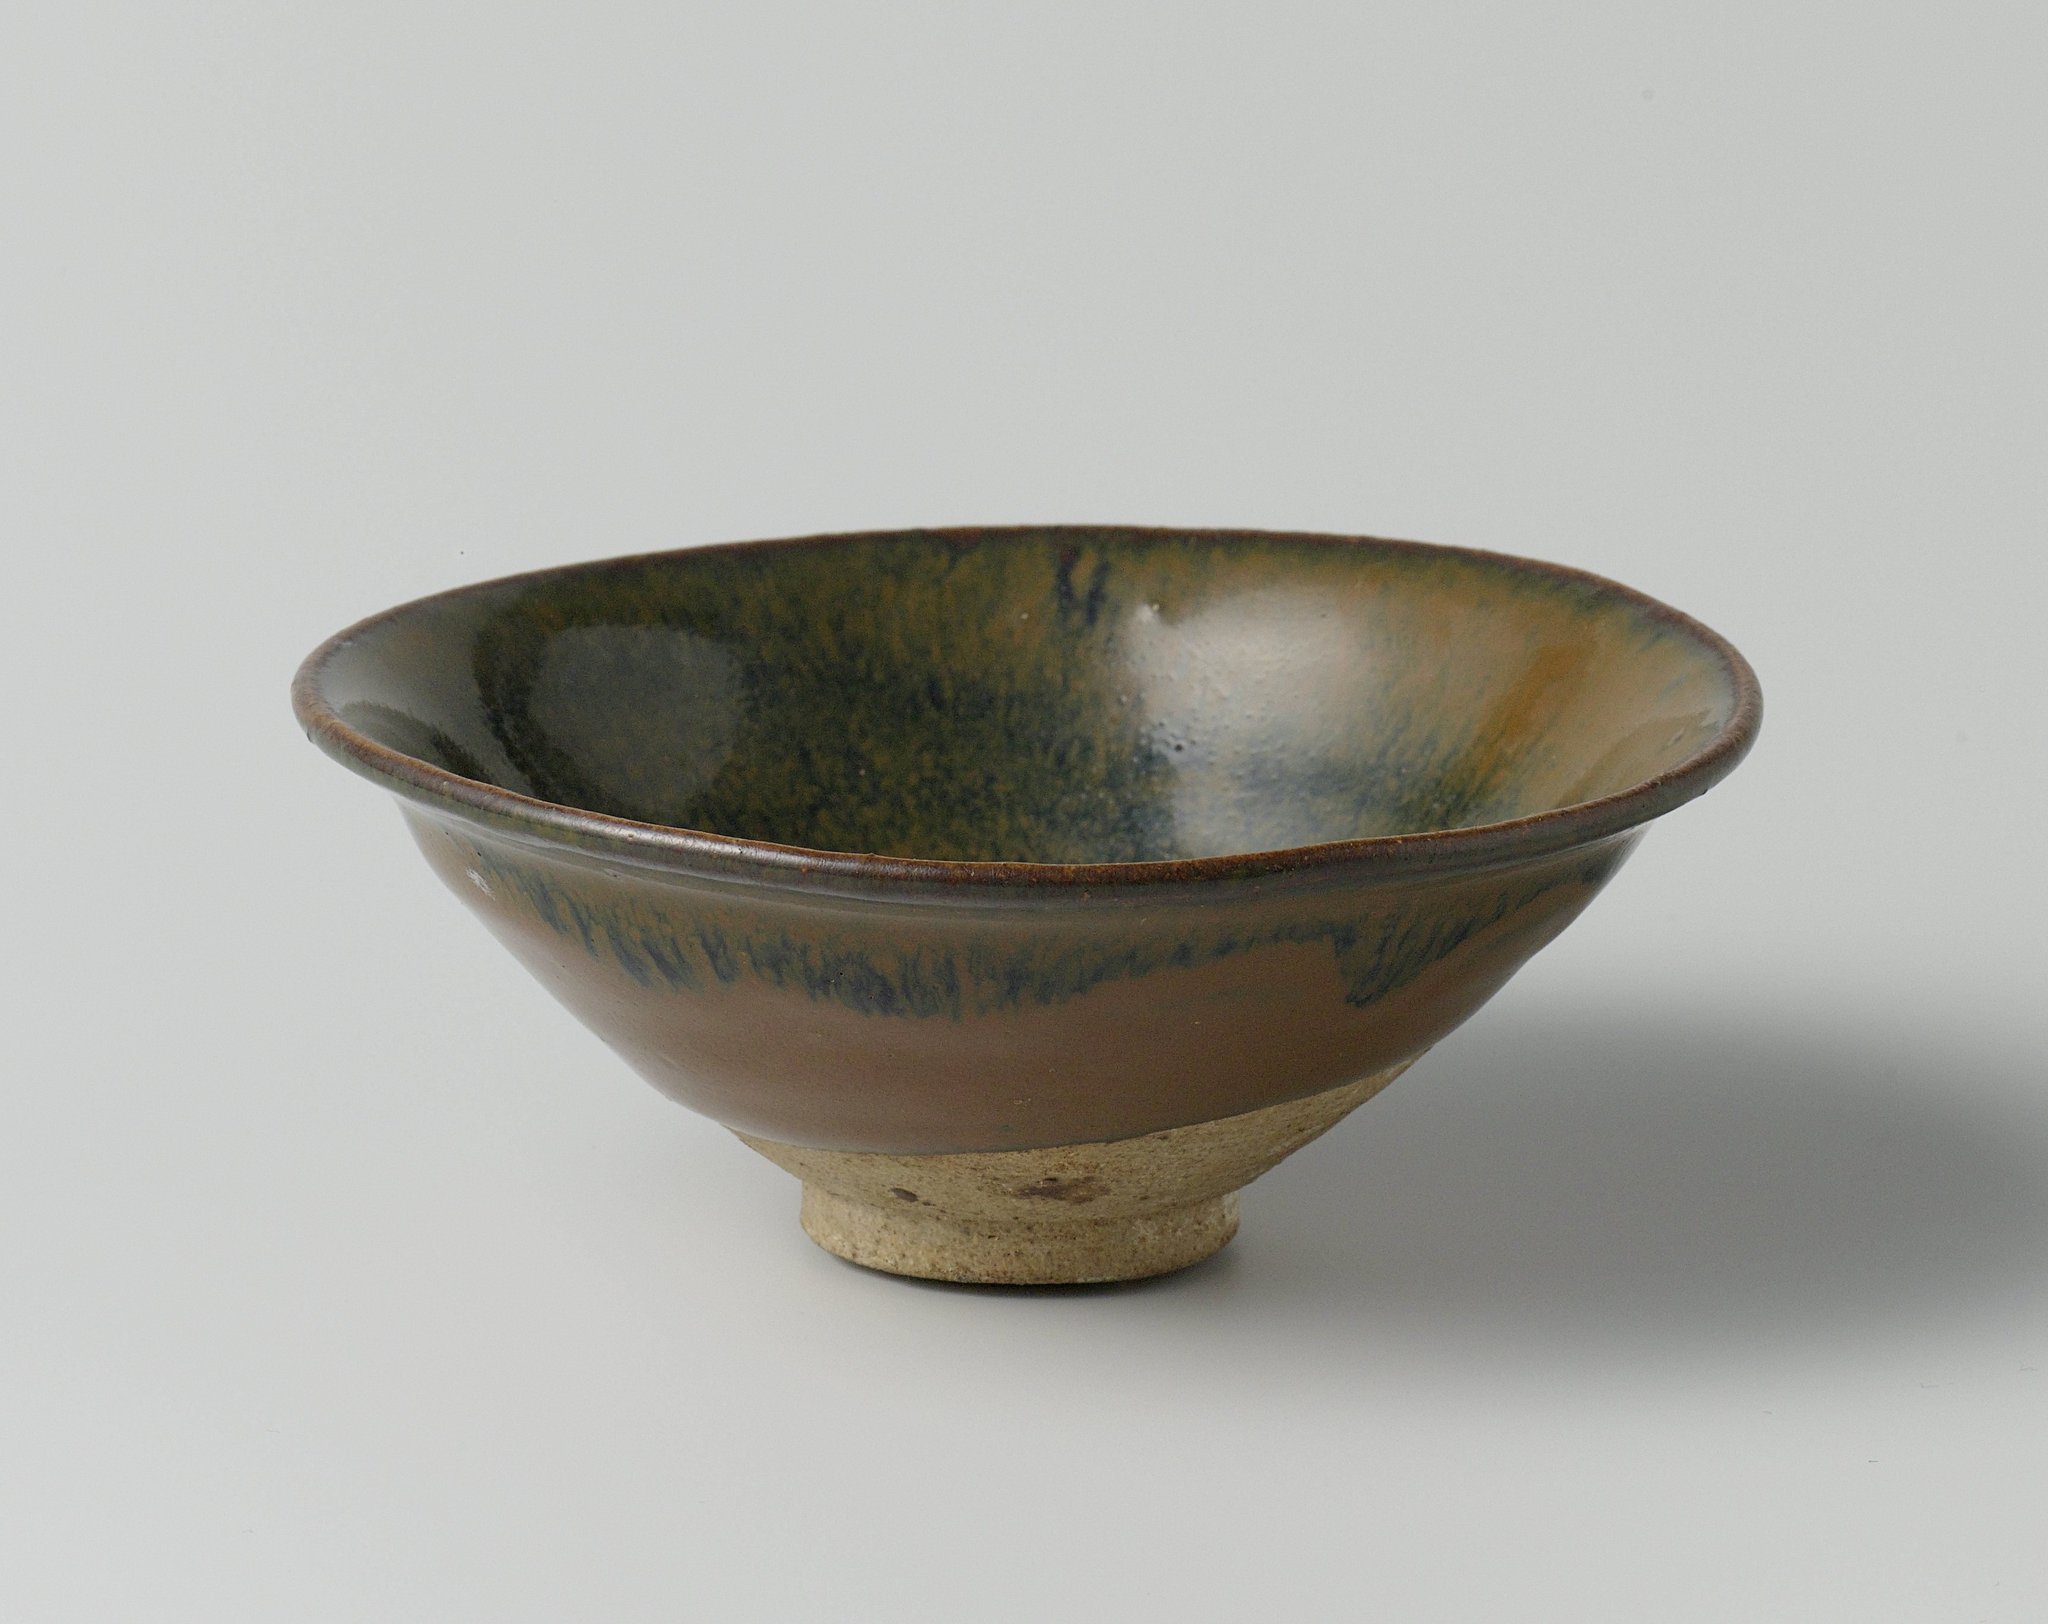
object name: tea bowl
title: Tea bowl with a bluish brown glaze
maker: Anonymous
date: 960-1279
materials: glaze, stoneware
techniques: firing, turning, vitrification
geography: china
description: Henan-ware tea bowls. China. Song period (960 - 1279). Glazed stoneware, Henan ware. The term Henan ware is used to describe tea bowls made in Northern China. Unlike Jian ware, for example, the forms and decorations used in Henan ware differ considerably. Westendorp bequest.